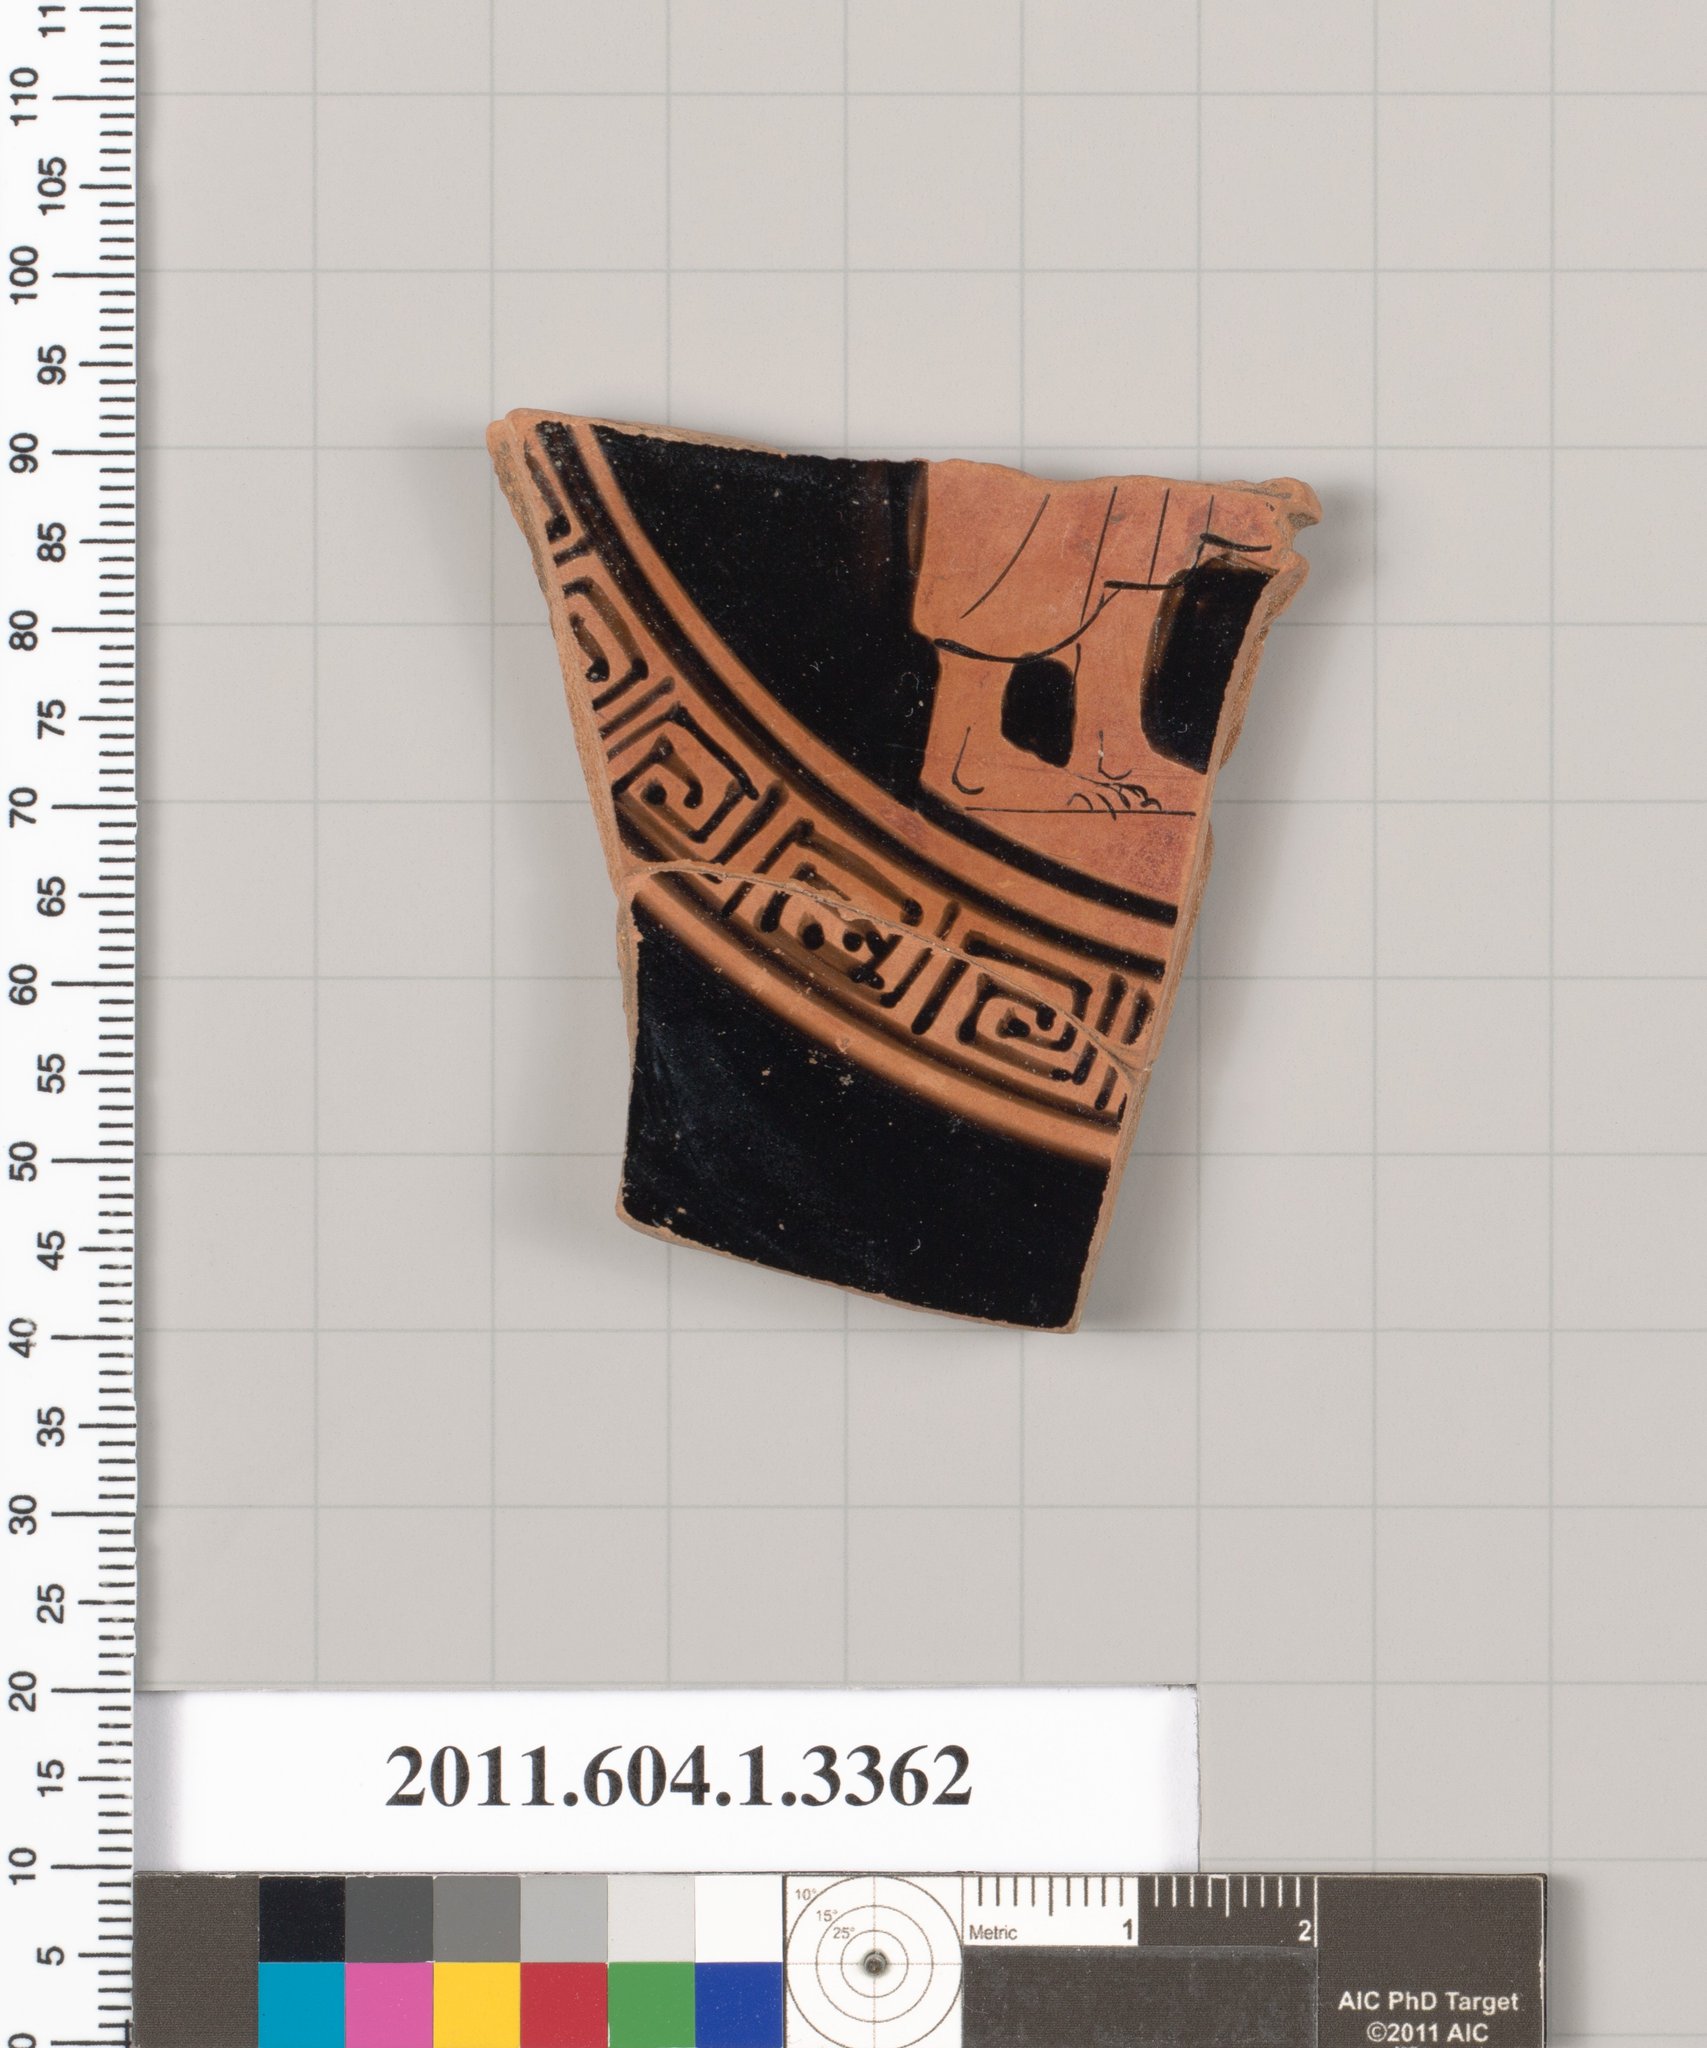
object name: kylix fragment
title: Terracotta fragment of a kylix (drinking cup)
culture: greek, attic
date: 475-451 BCE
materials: terracotta